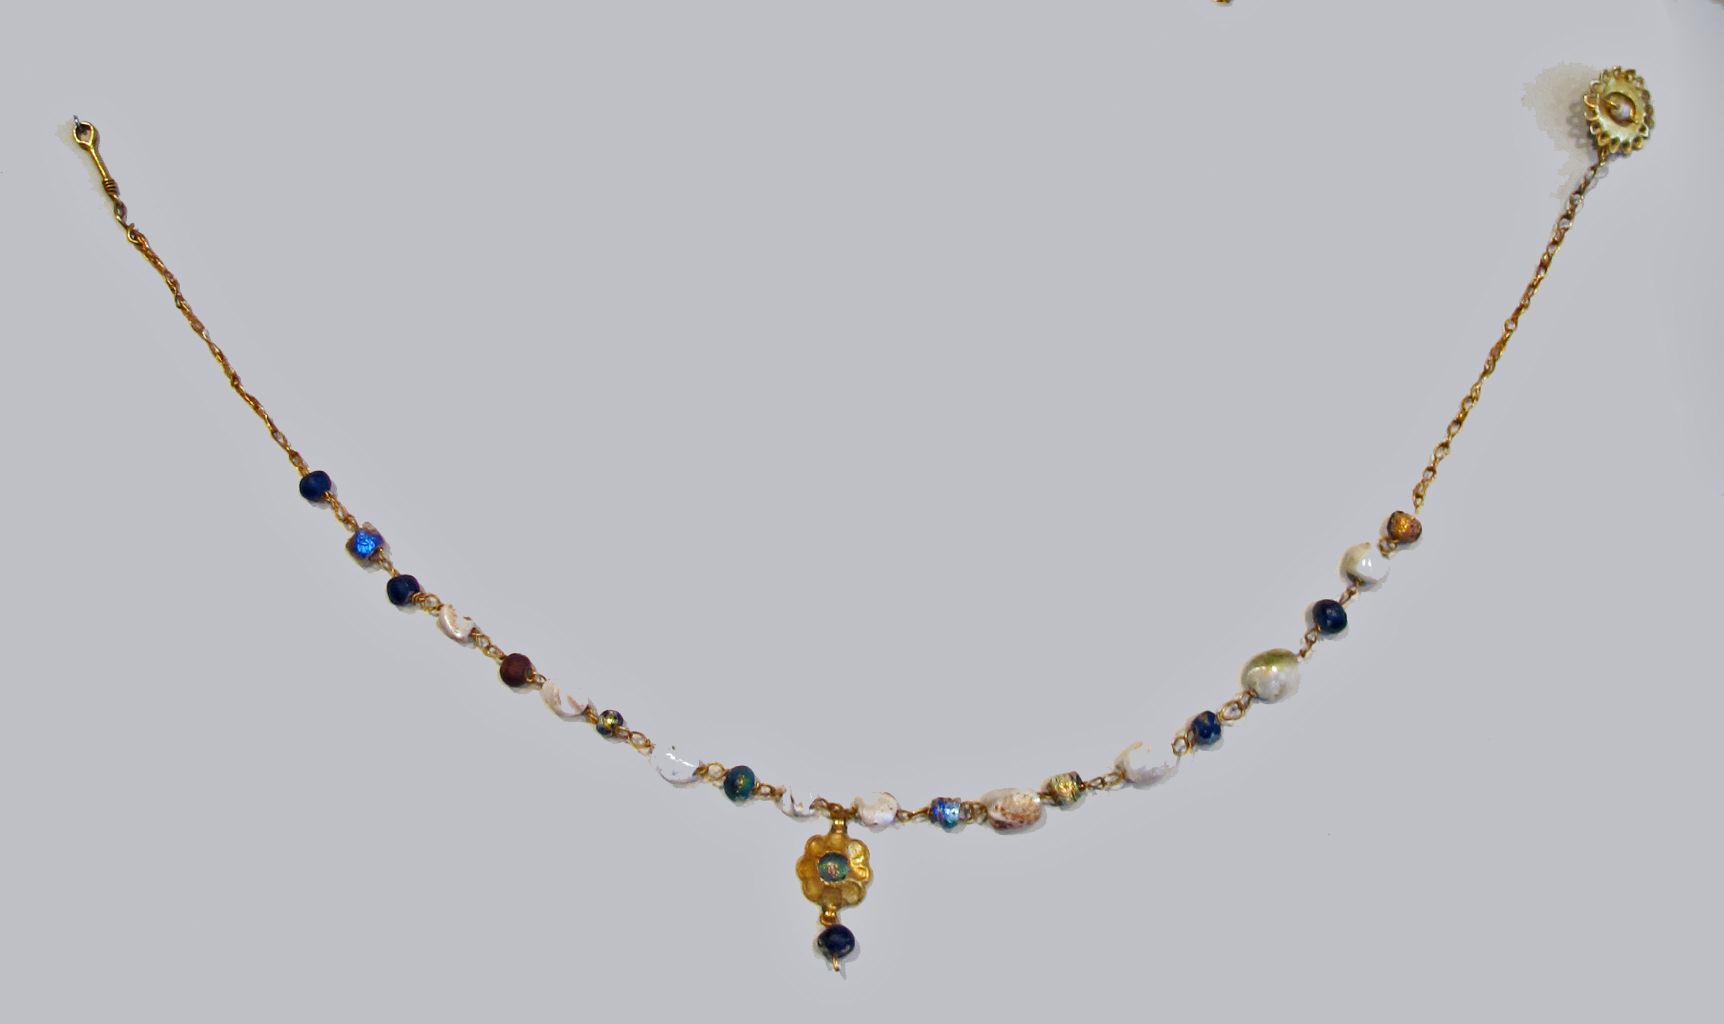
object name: necklace with glass bead and pearl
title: Gold, pearl, and glass necklace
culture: roman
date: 1-100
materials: glass, gold